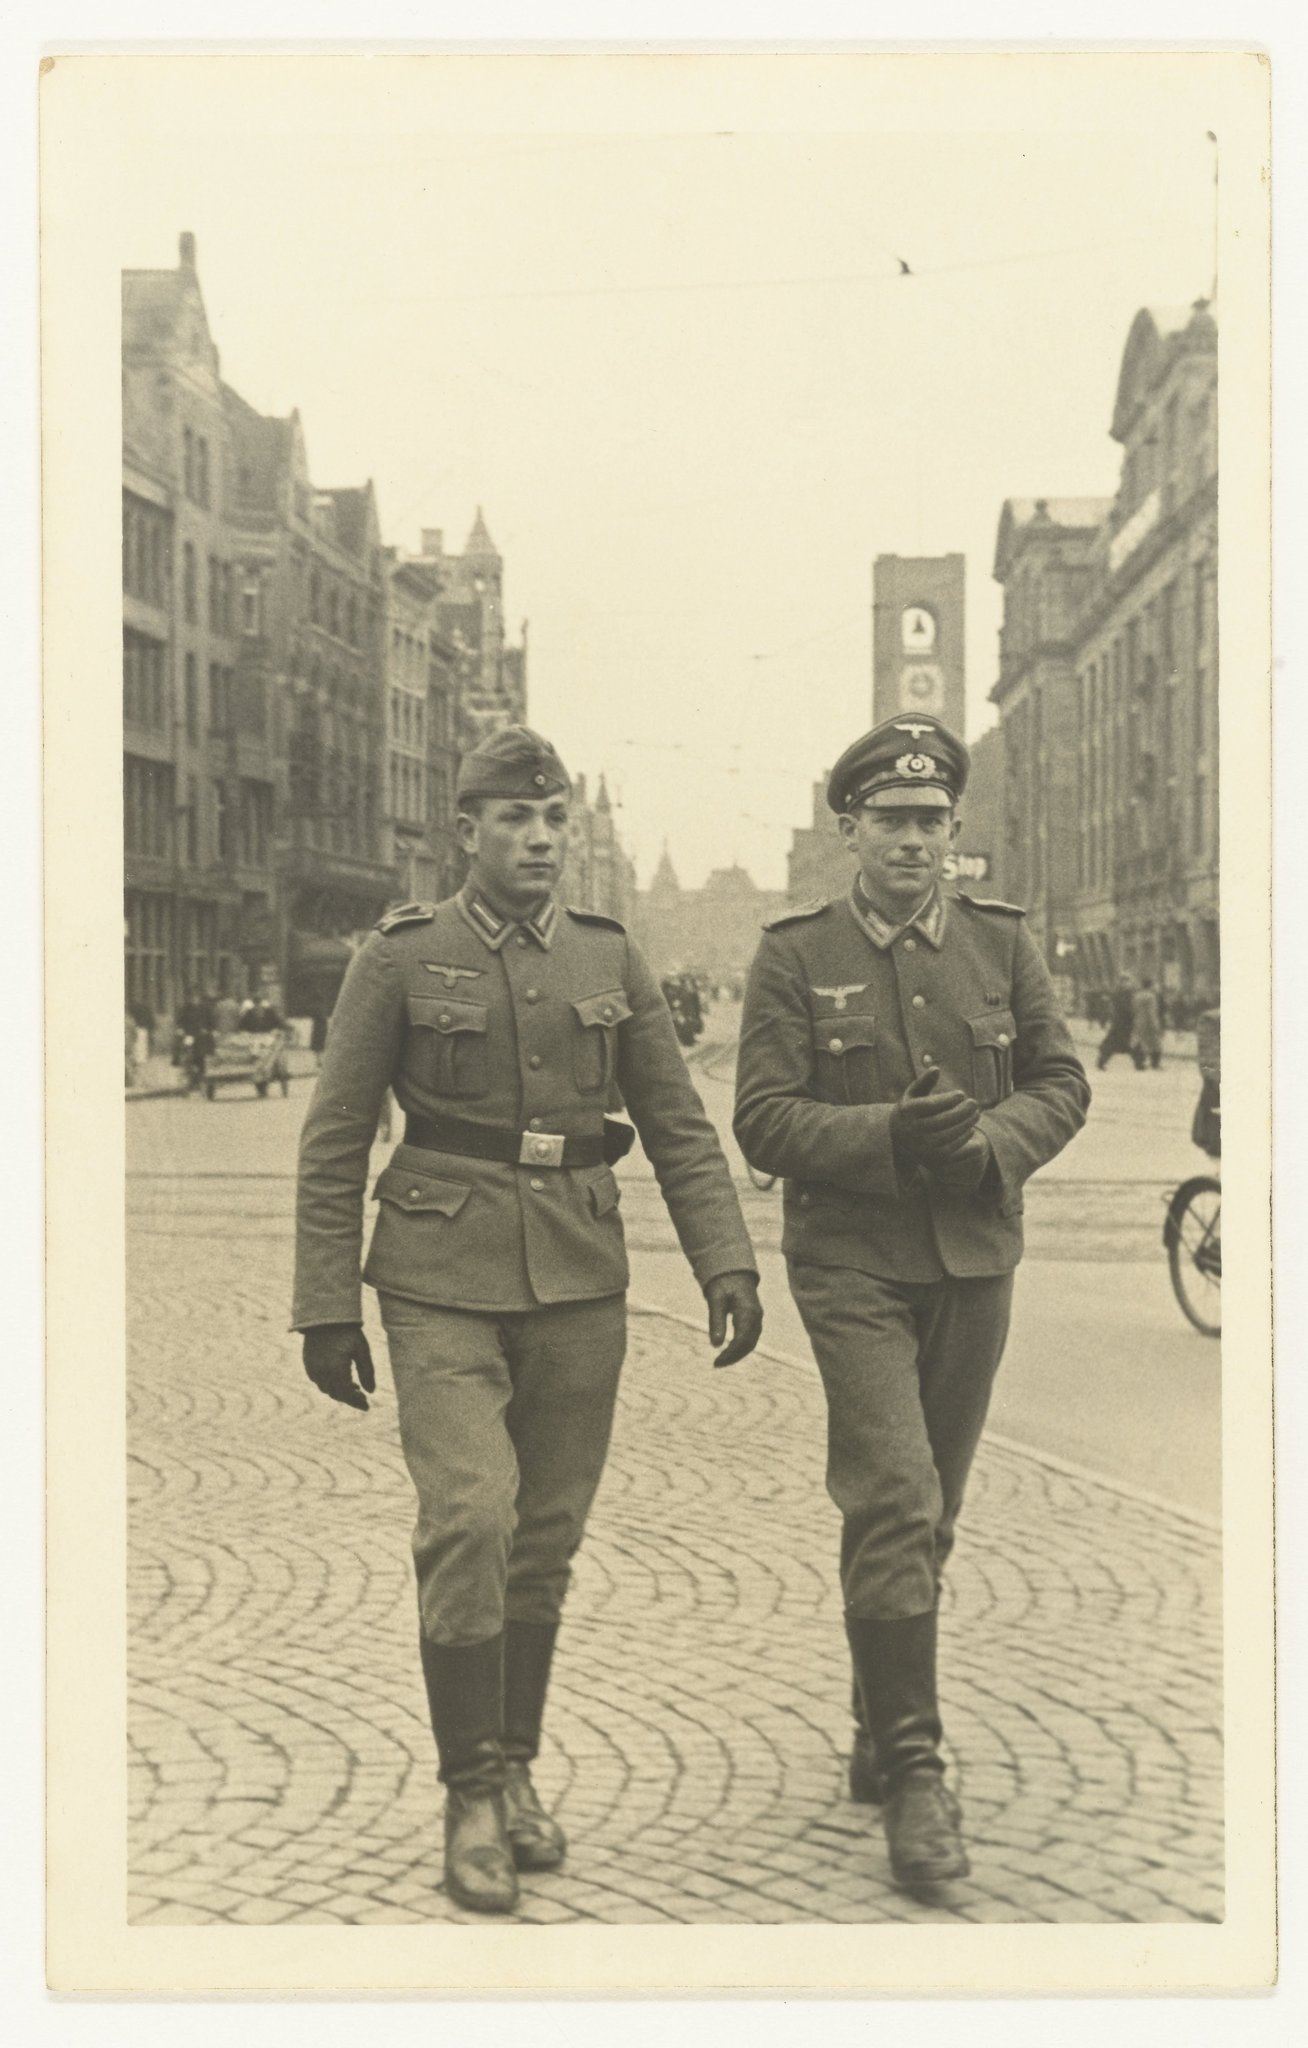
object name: photograph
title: Twee Wehrmachtsoldaten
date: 1911-1941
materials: photographic support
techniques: gelatin silver print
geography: amsterdam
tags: occupation ~ war, amsterdam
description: Twee Wehrmachtsoldaten, een van de Luftwaffe, lopen in Amsterdam over de Dam bij de Bijenkorf. Zelfde twee soldaten als op nr. NG-2007-5-46. Het zou gaan om leden van een kustwachtbatterij.